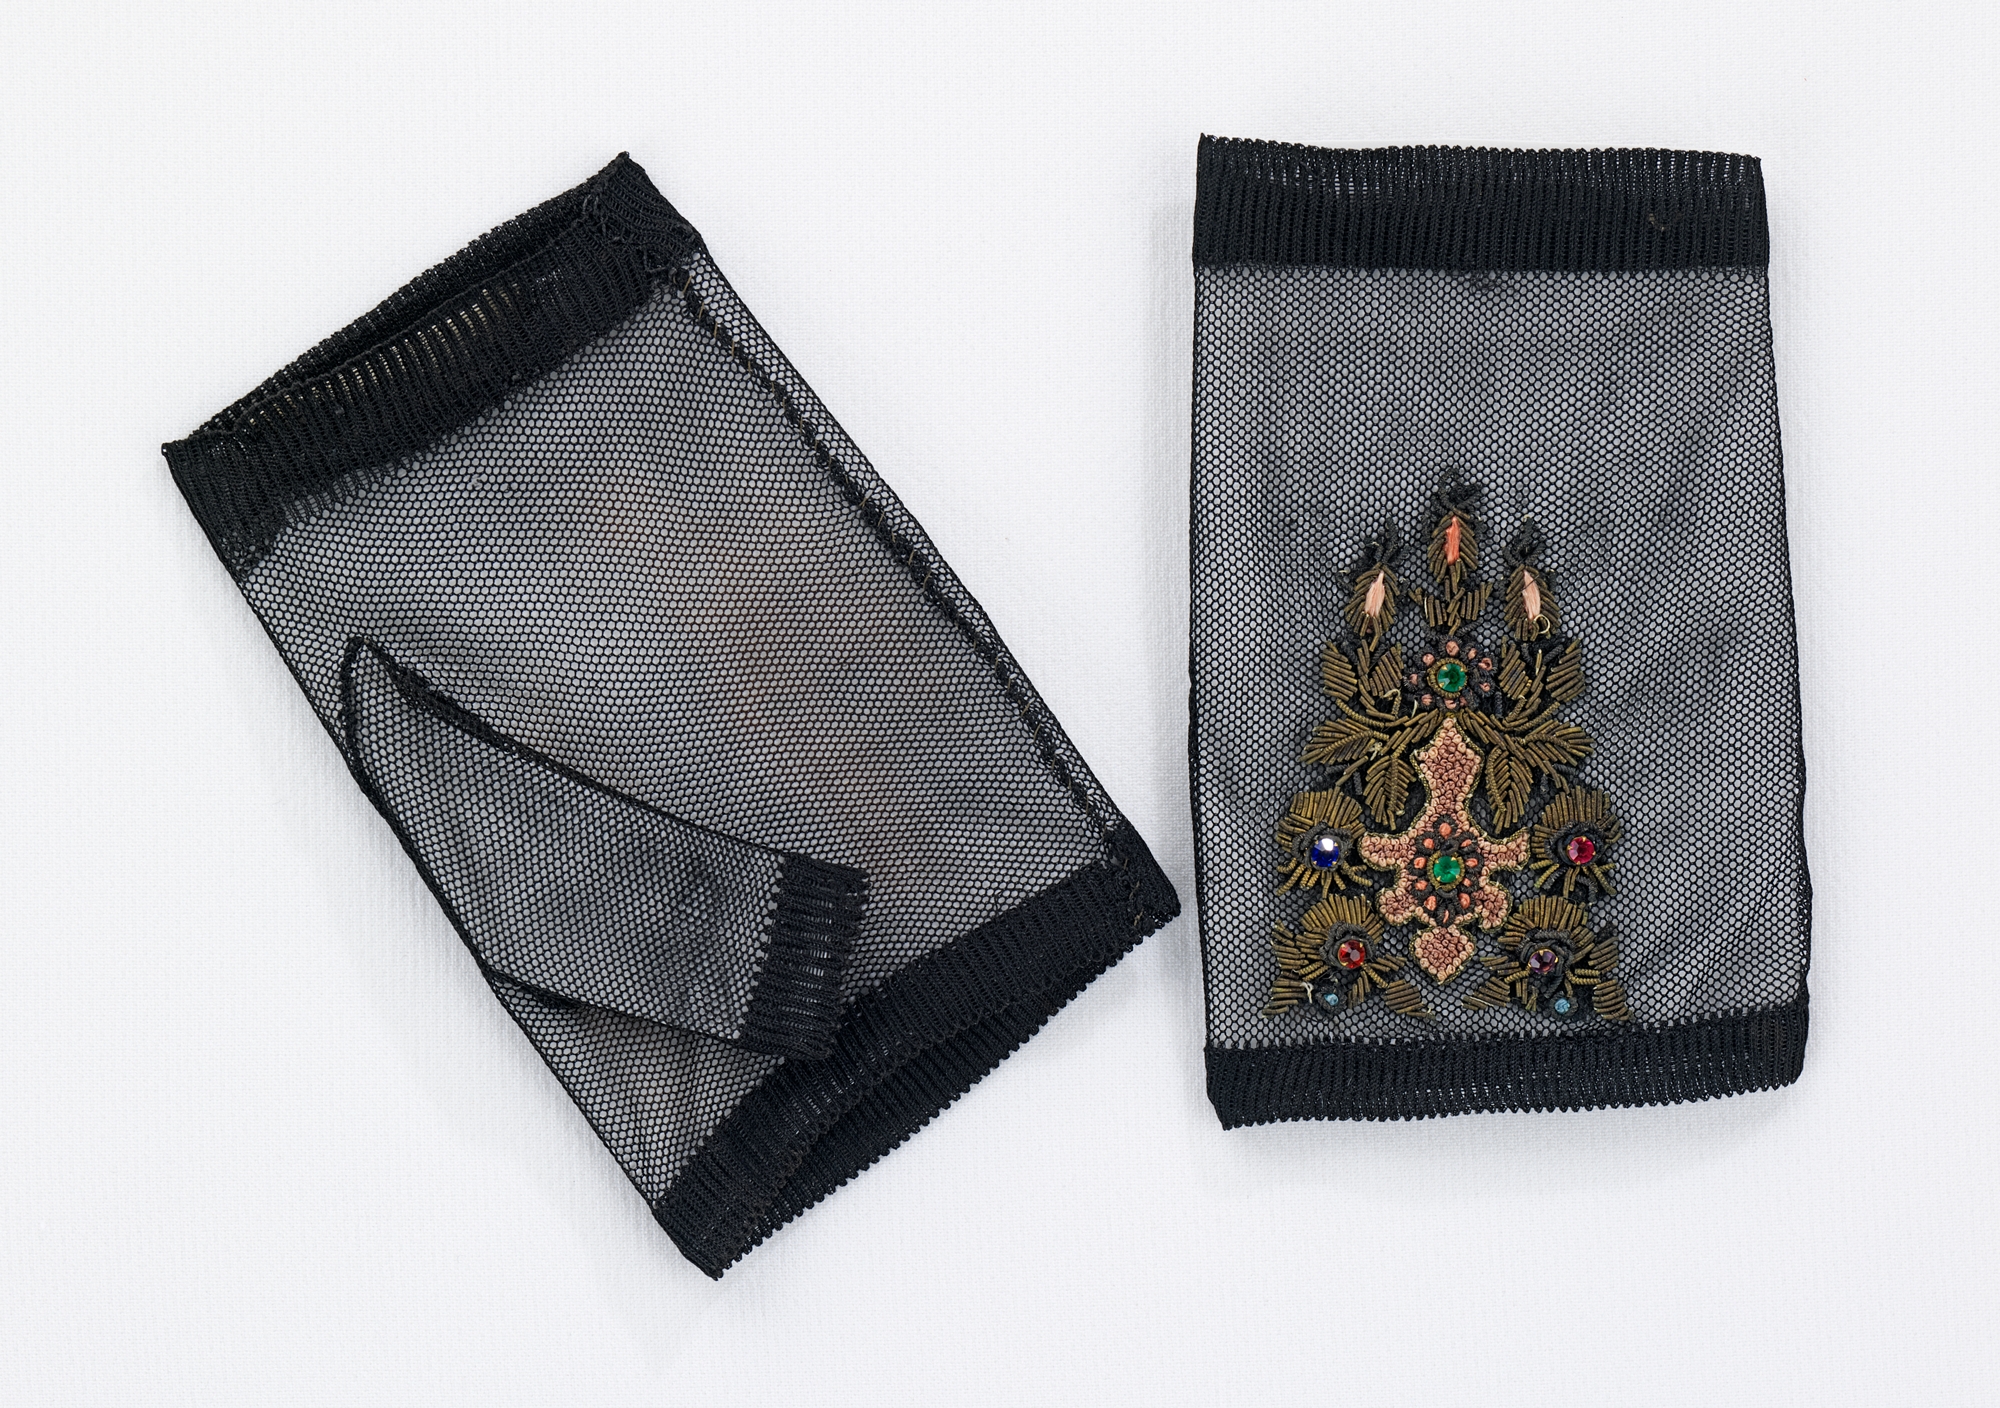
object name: mitt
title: Mitts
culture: american or european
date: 1876-1900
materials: glass, metal, silk